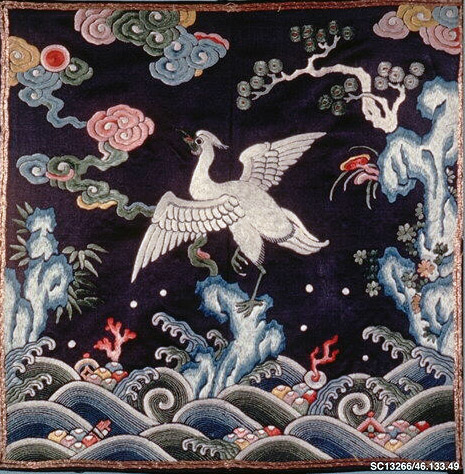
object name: rank badge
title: Rank Badge with Egret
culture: chinese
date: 1701-1733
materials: metal thread, silk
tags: birds